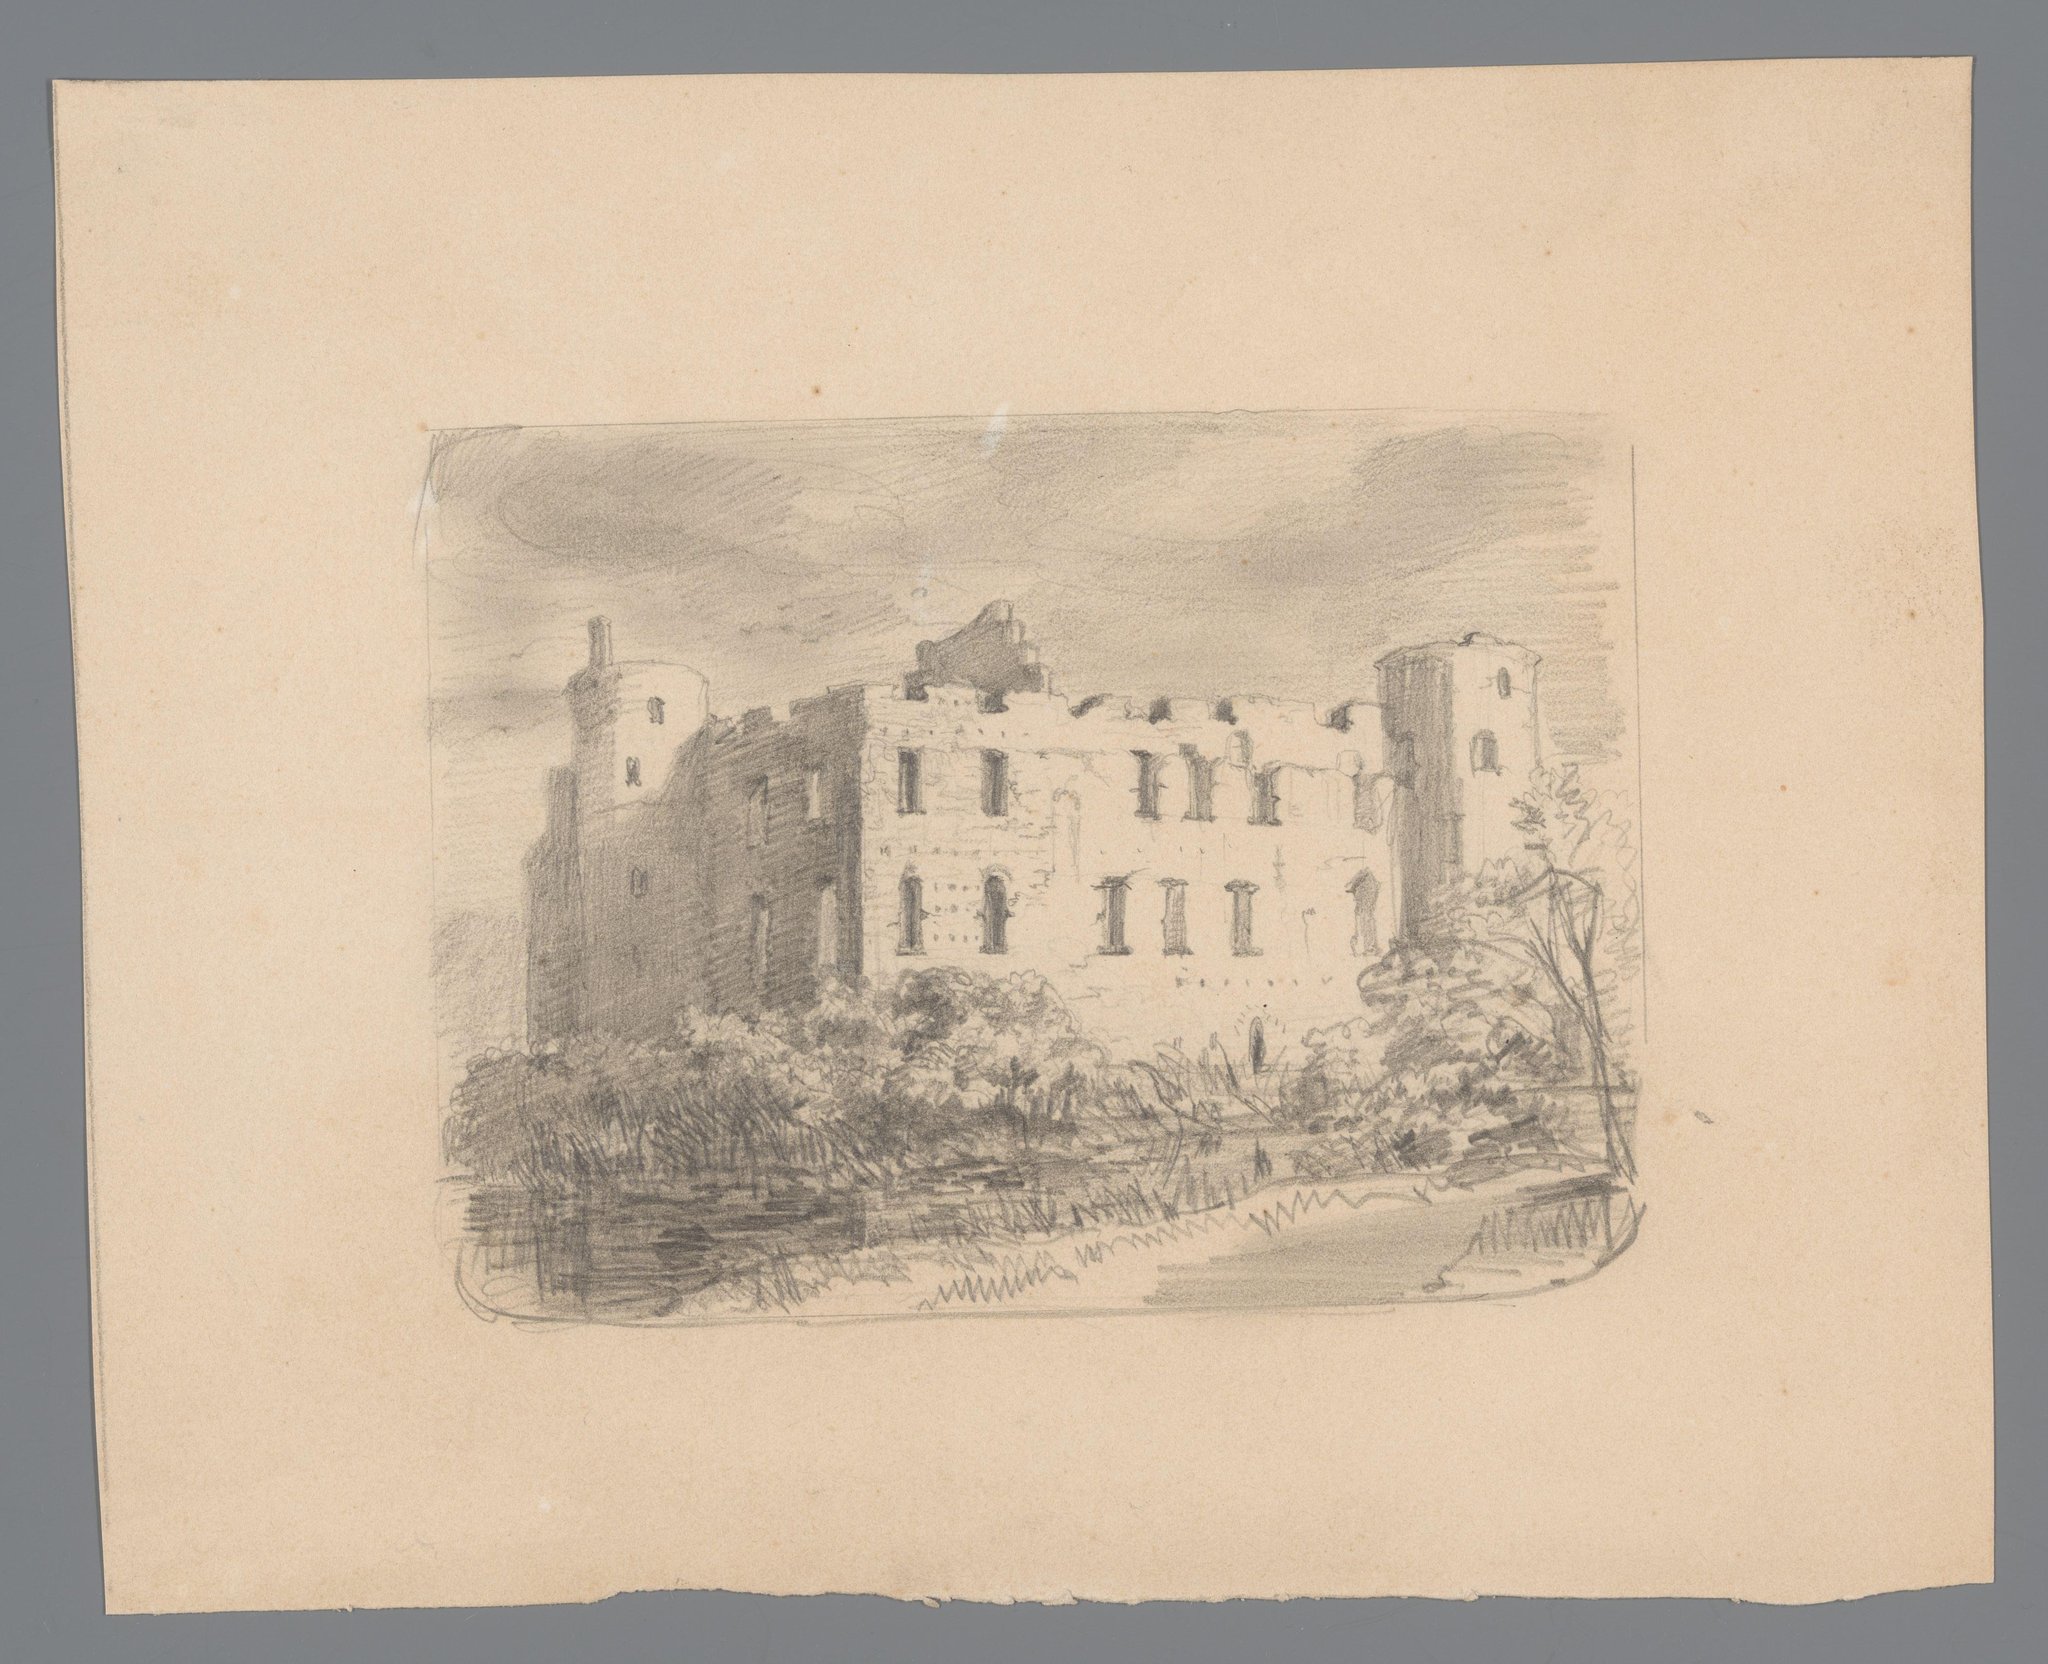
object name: drawing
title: Gezicht op de ruïne van Kasteel de Haar in Haarzuilens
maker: david van der kellen (1827-1895)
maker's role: draughtsman, print maker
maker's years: 1827-1895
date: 1837-1895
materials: paper, pencil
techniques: drawing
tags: castle, landscape with tower or castle, ruin of a dwelling, house, castle, etc.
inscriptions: collector's mark: Lugt 2228